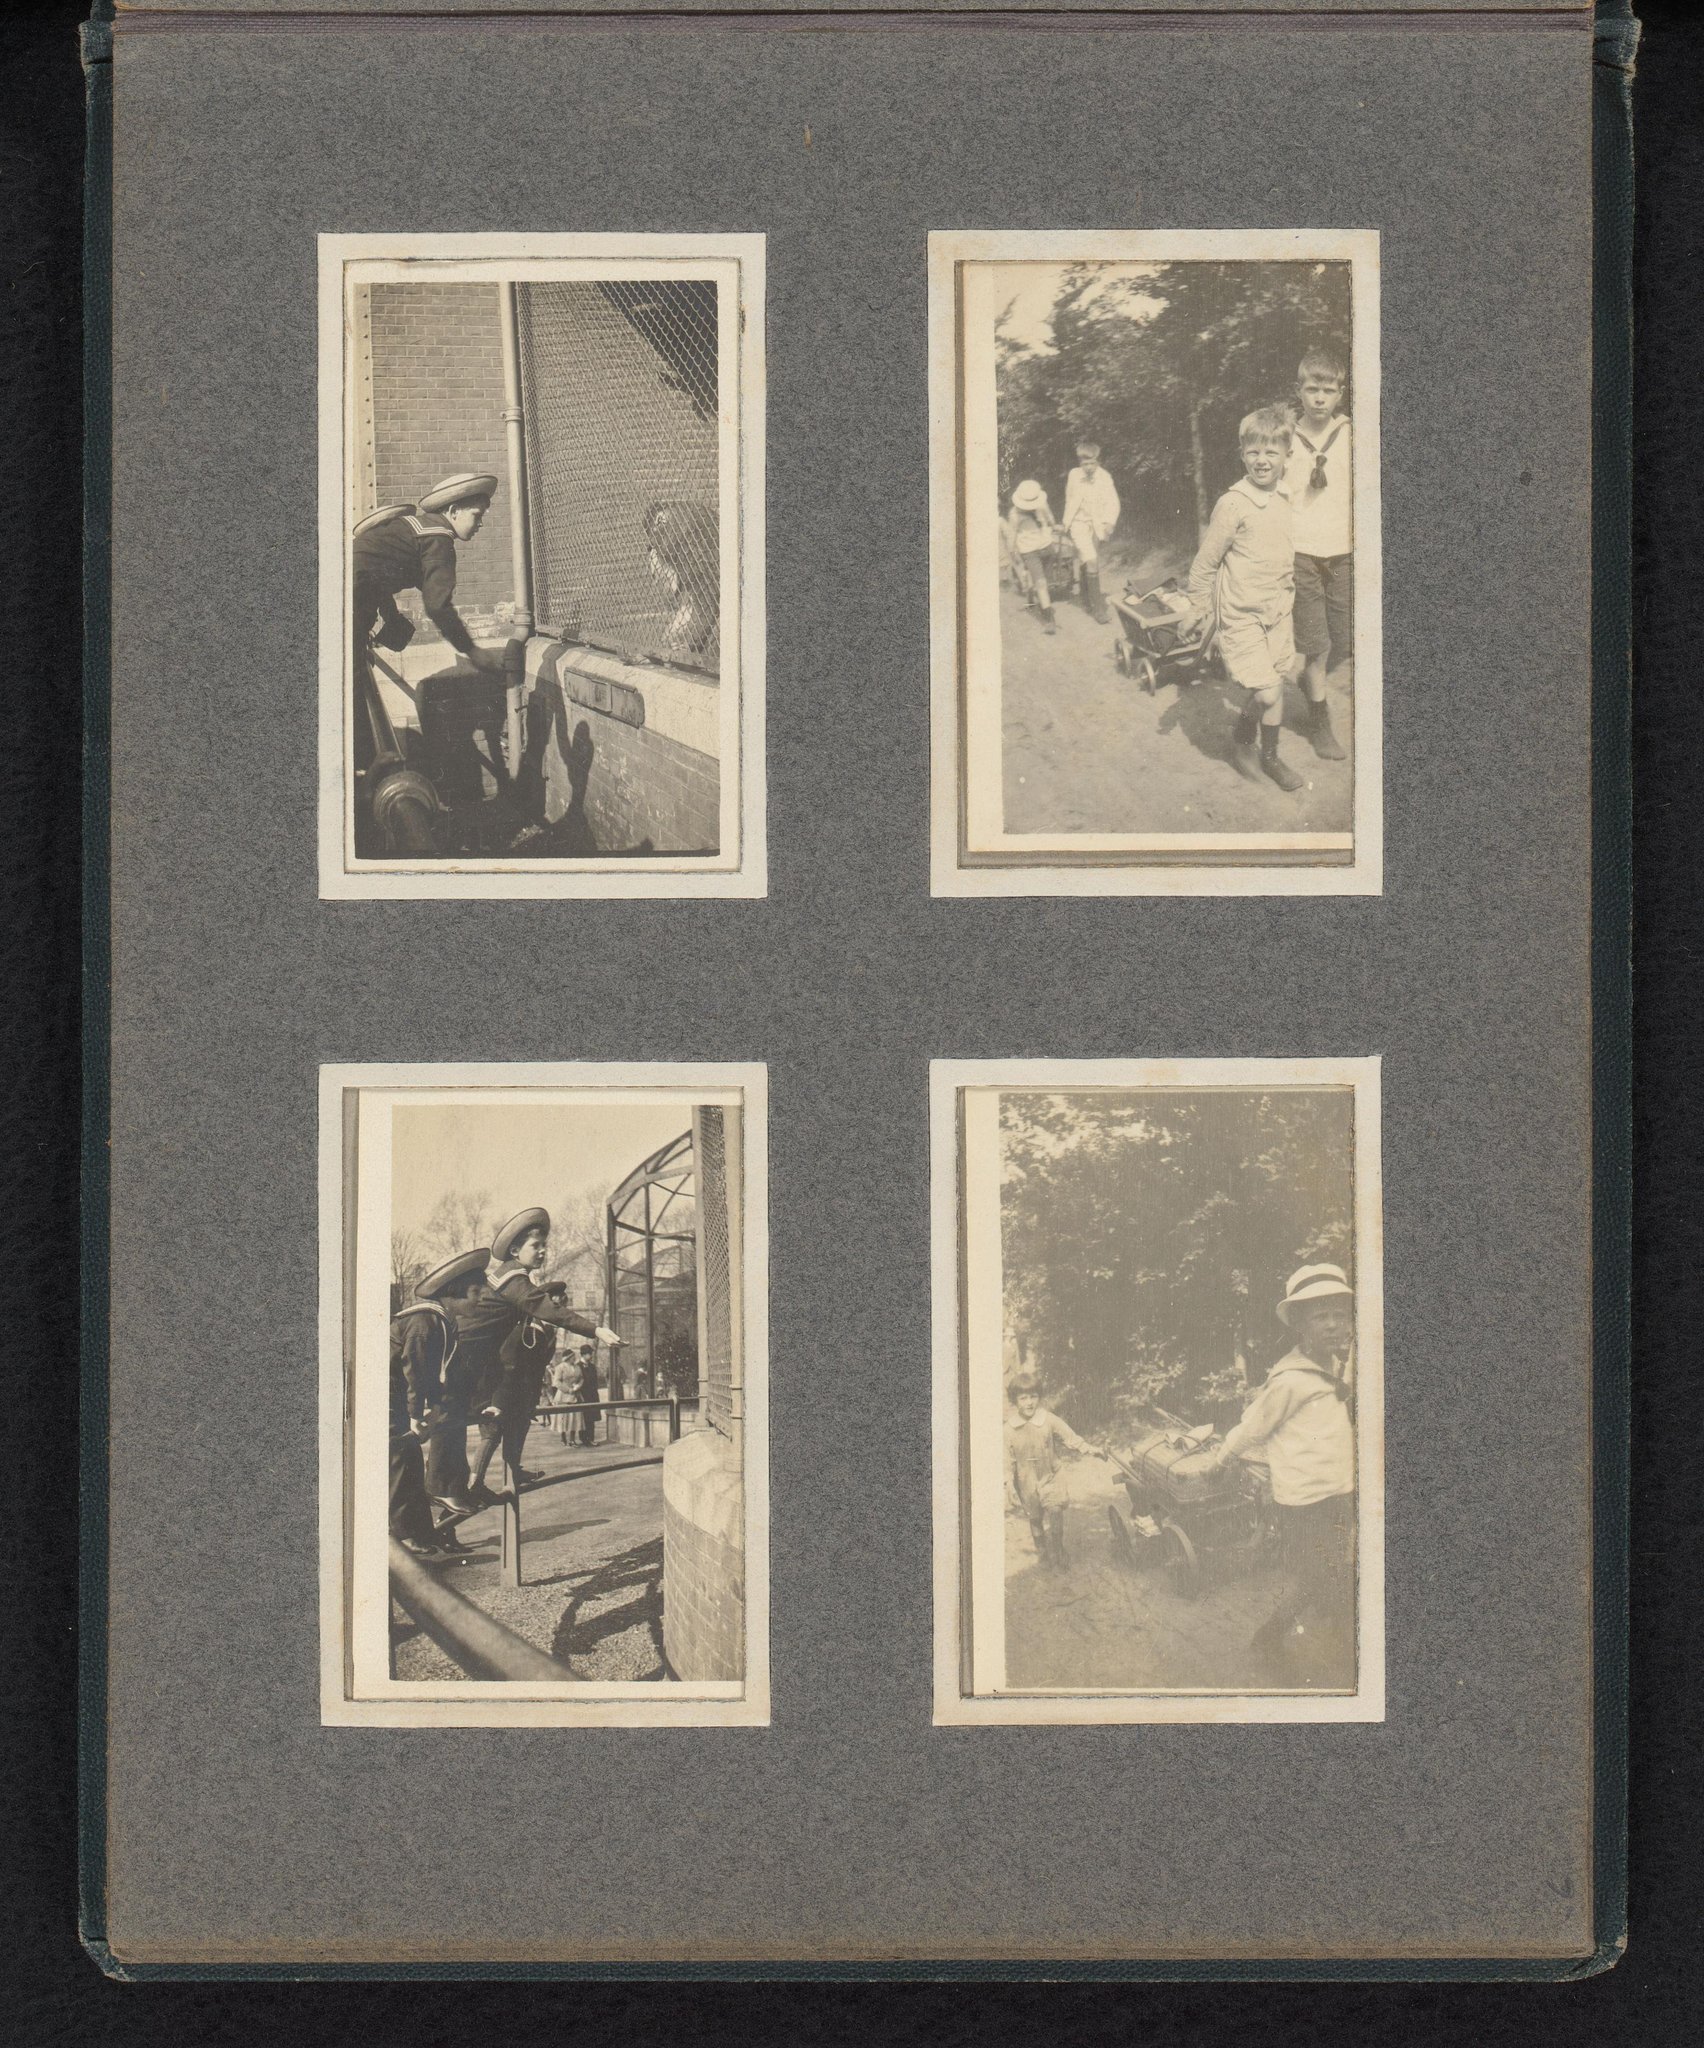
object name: photograph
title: Carel en Frank van den Berg in Artis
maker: hendrik herman van den berg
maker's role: amateurfotograaf, jurist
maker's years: 1875-1944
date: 1918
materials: paper, cardboard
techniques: gelatin silver print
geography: amsterdam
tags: amsterdam, carel frederik van den berg (cay), frank willem van den berg (1912-1998), zoo (as place of recreation)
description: Deze foto's zijn onderdeel van een album.